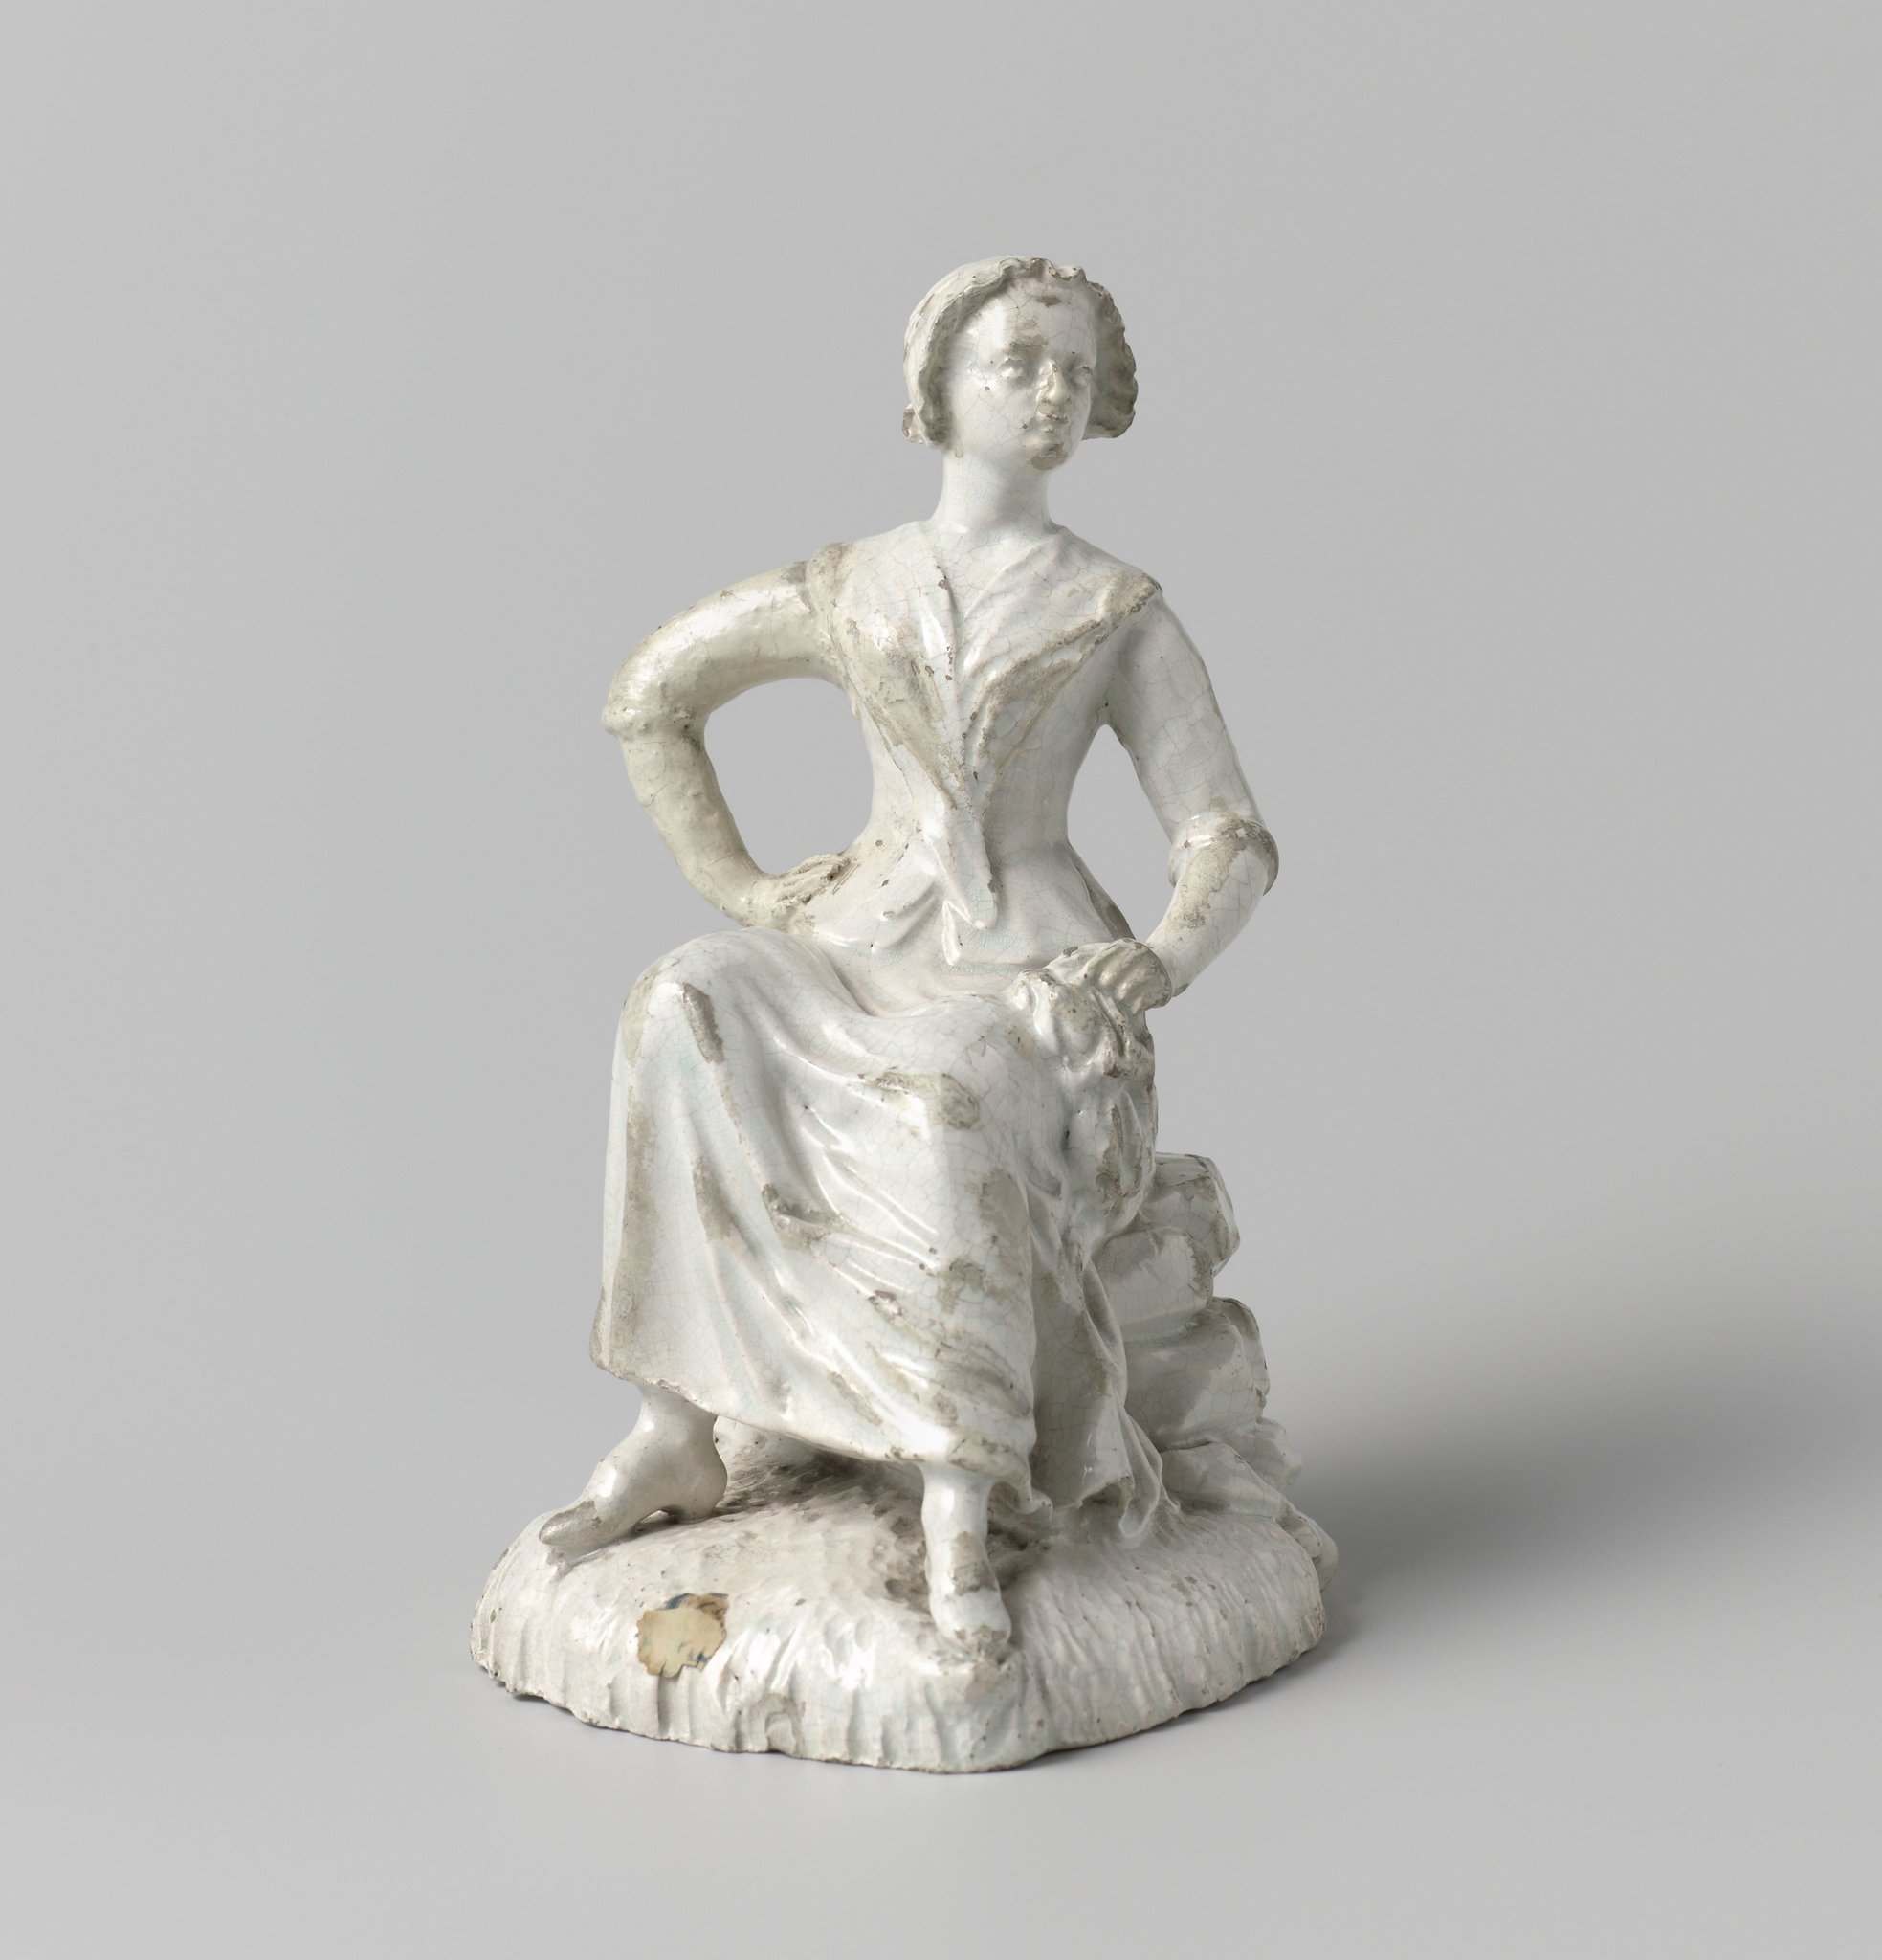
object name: decoratief object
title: Beeld van Engels hardgebakken aardewerk, faience fine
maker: Anonymous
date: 1780-1820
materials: earthenware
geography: france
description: Beeld van hardgebakken aardewerk. Het beeld stelt een zittende vrouw voor.